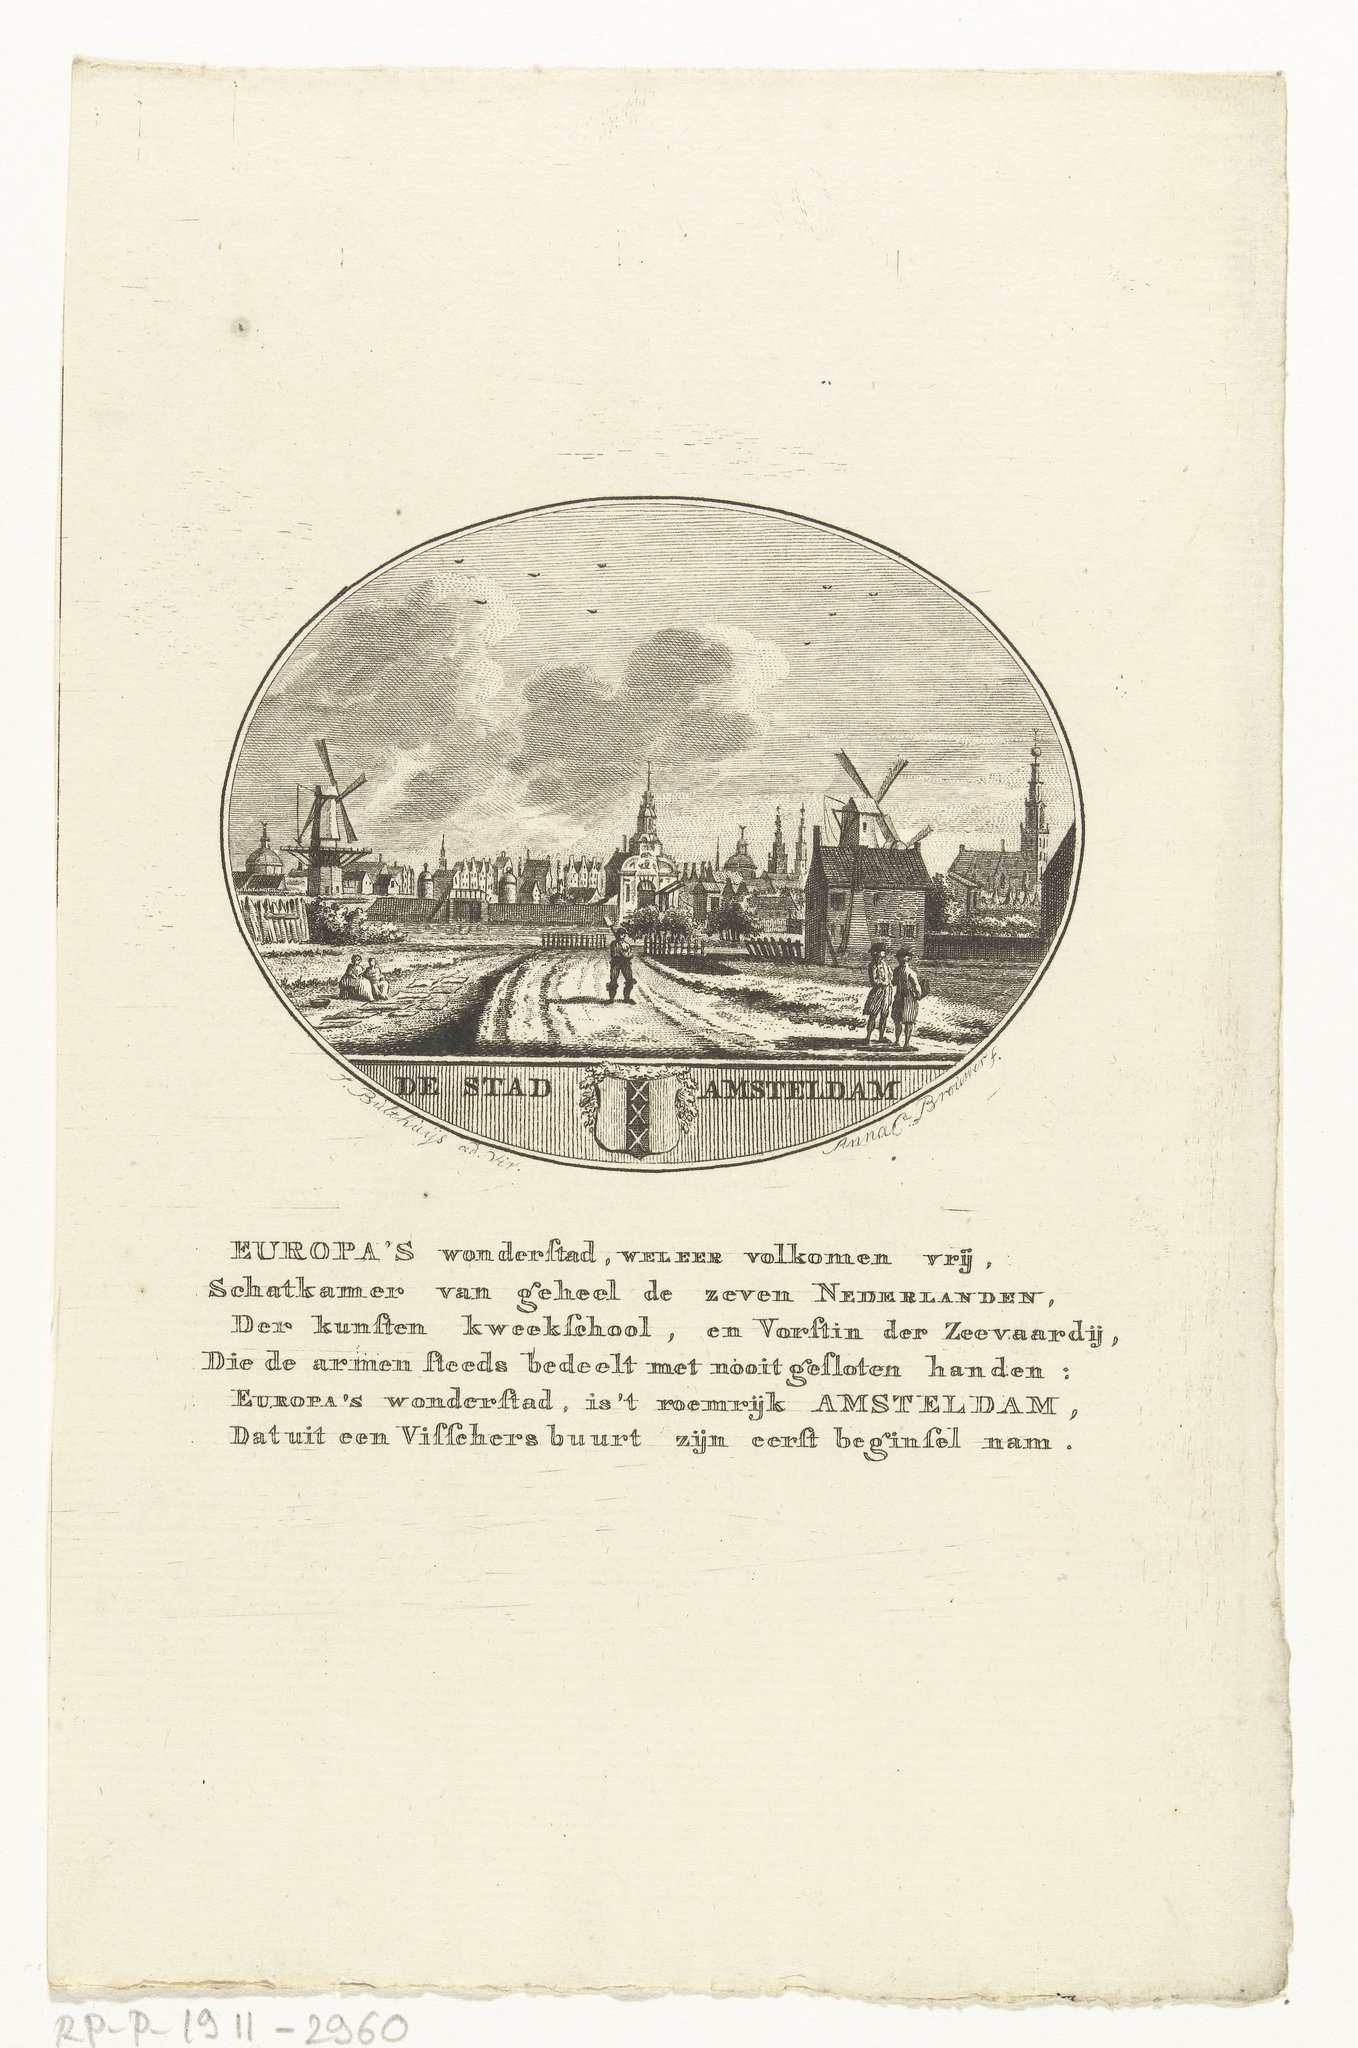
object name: print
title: De stad Amsteldam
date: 1793-1795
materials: paper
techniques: etching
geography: amsterdam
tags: city-view in general; 'veduta', amsterdam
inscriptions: collector's mark: Lugt 2228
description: afkomstig uit: L. van Ollefen, De Nederlandsche stad- en dorp-beschrijver. Deel 3, Amsterdam: Hendrik Arend Banse, 1795.